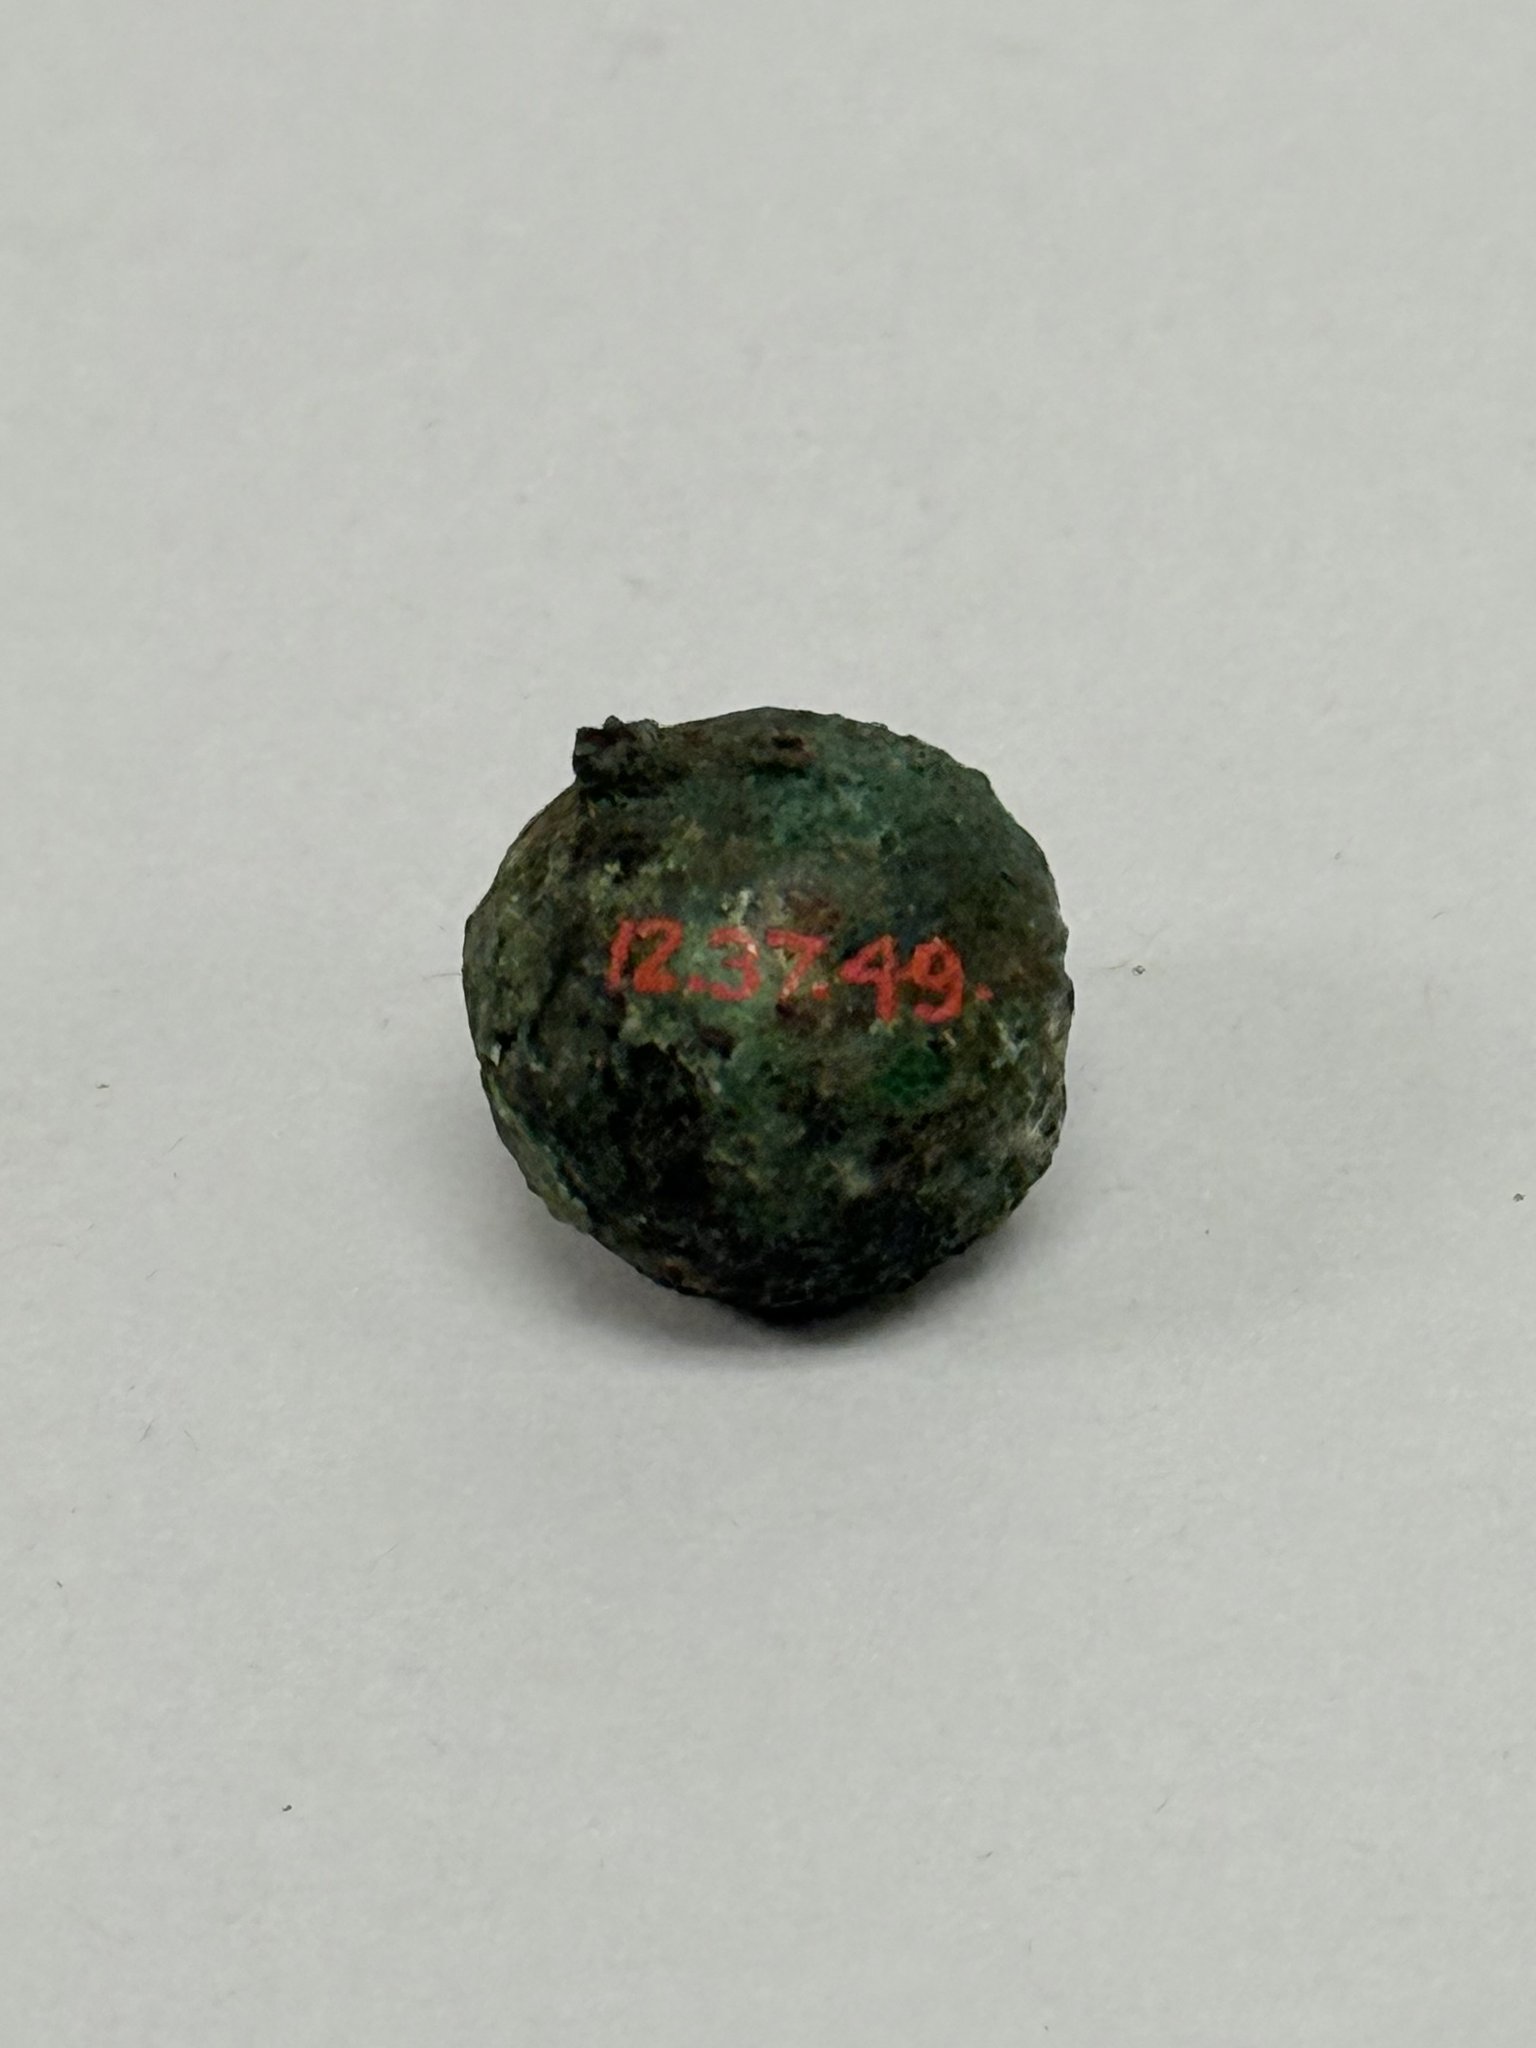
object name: bell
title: Wrist Bell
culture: japanese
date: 601-700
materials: copper